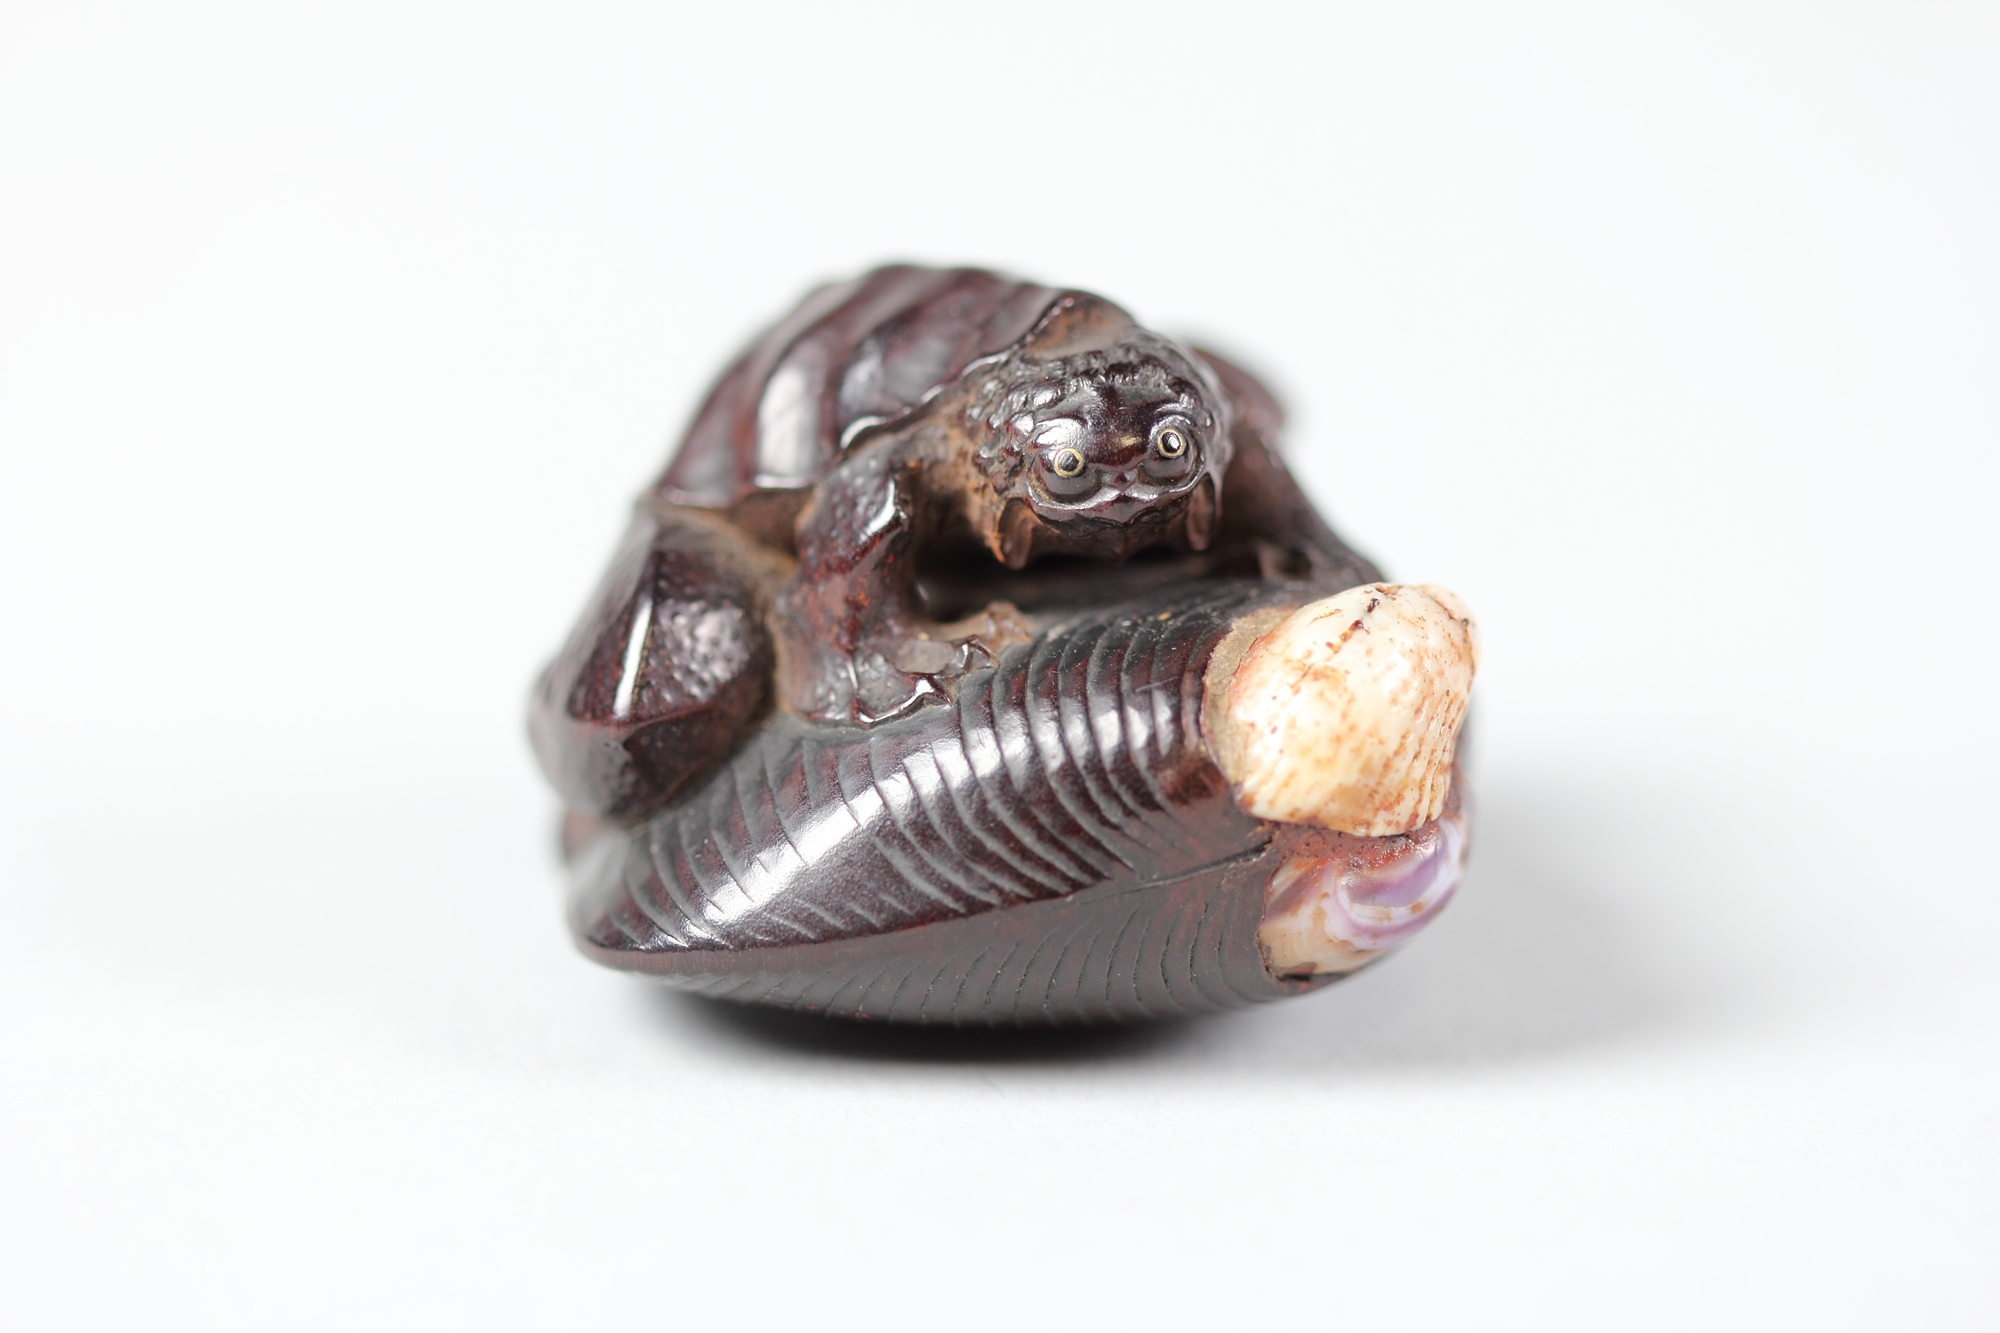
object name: netsuke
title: Netsuke of Frog-like Tortoise on a Shell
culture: japanese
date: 1701-1800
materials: wood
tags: turtles,shells